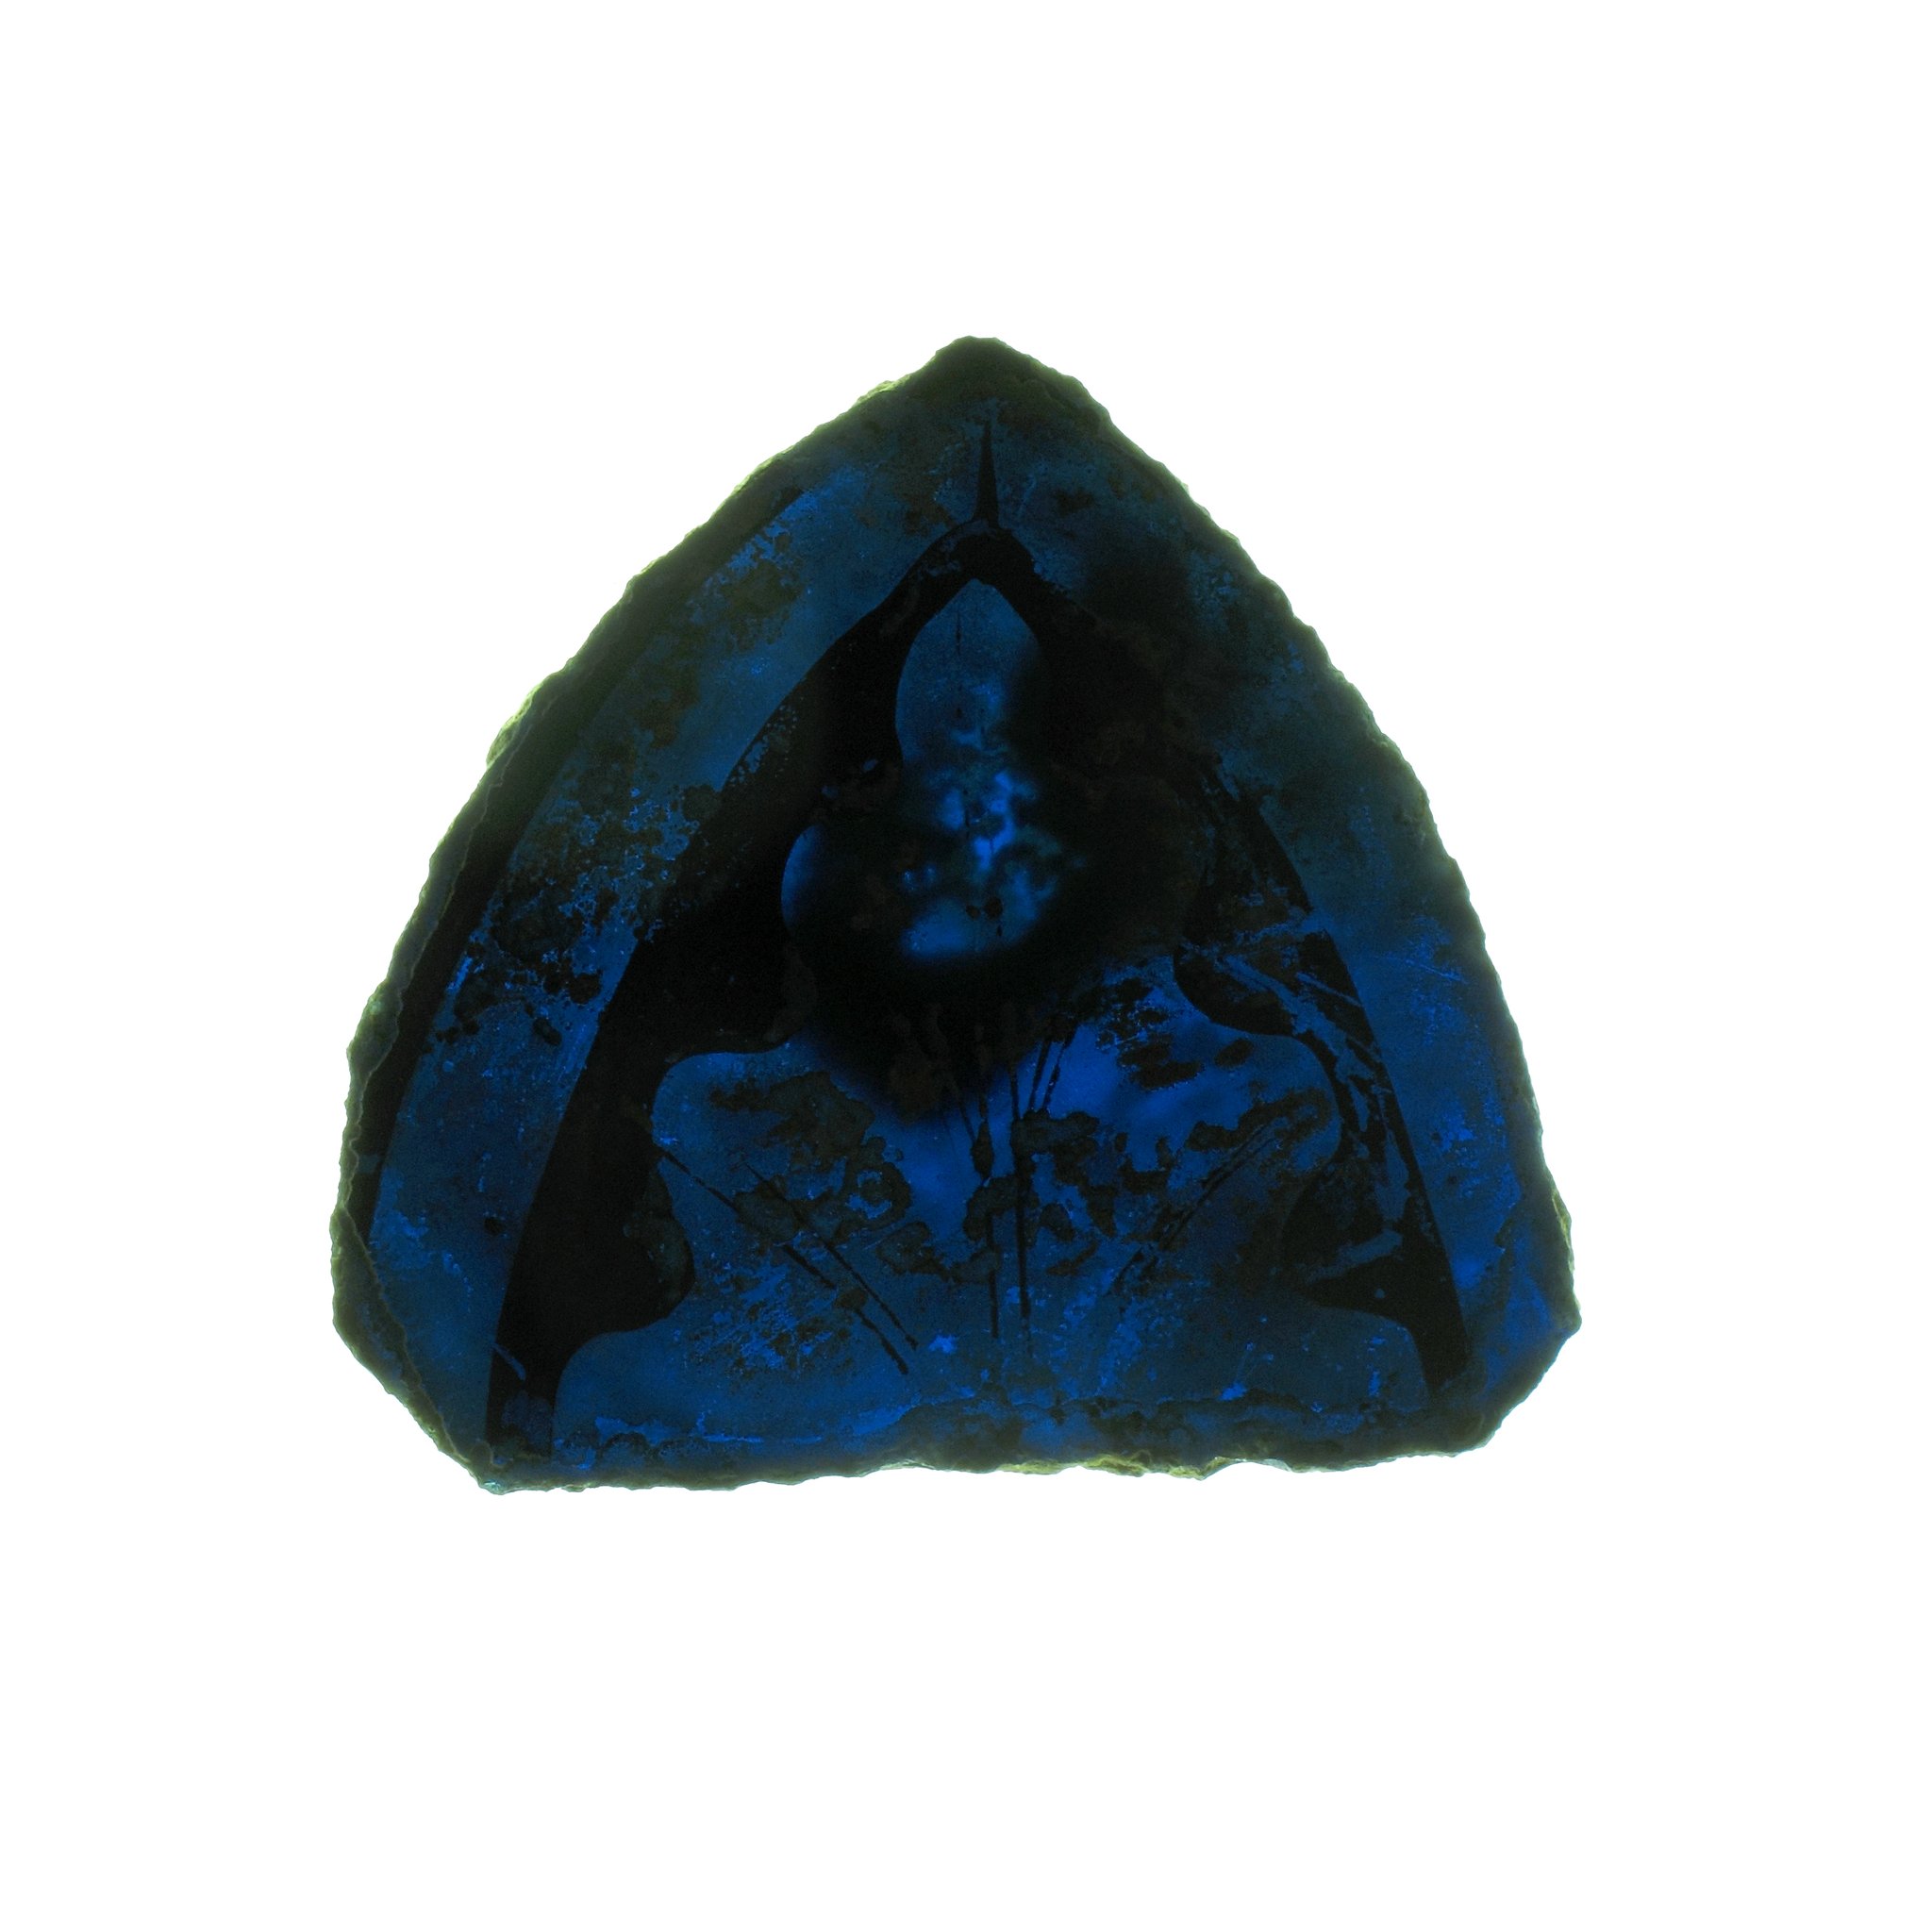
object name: fragment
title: Glass Fragment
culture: european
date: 1201-1400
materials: glass, metal